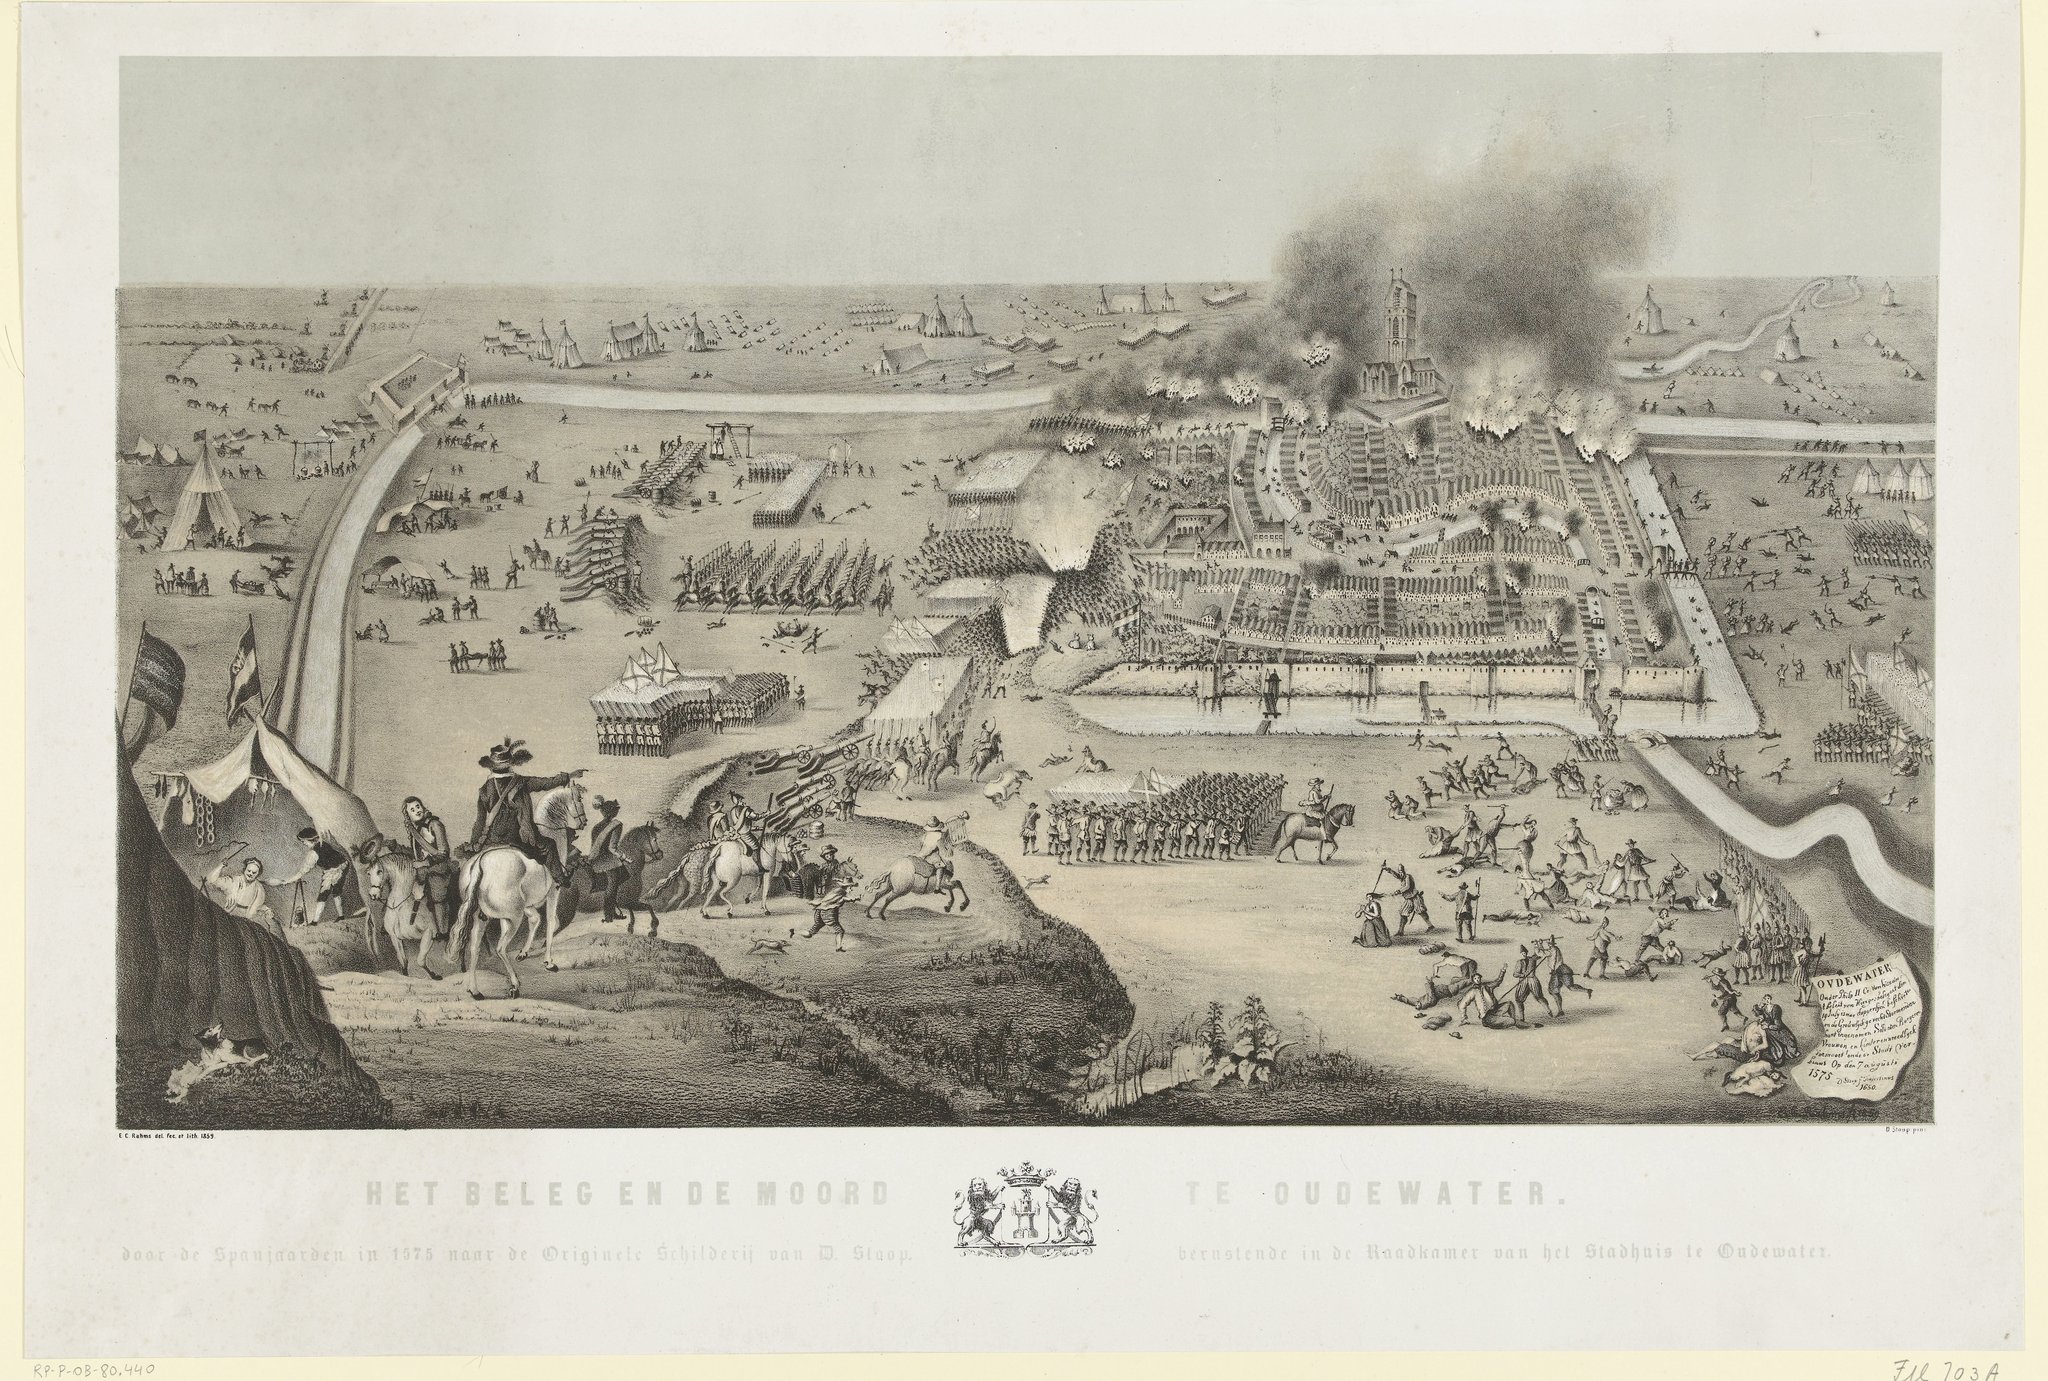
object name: historical object representation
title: Moord te Oudewater, 1575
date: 1859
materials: paper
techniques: tone lithography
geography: netherlands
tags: maastricht, politician, siege, position war, massacre ~ war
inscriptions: date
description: Beleg en moord door de Spanjaarden onder Hierges te Oudewater, 8 augustus 1575. Gezicht op brandende stad en omgeving met de posities van de Spanjaarden; burgers die de stad proberen te verlaten worden door de soldaten gedood. Met titel en stadswapen onder de voorstelling. Rechts in de voorstelling een banderol met onderwerp en naam maker. Naar het schilderij van Dirk Stoop uit 1650 in het stadhuis van Oudewater.